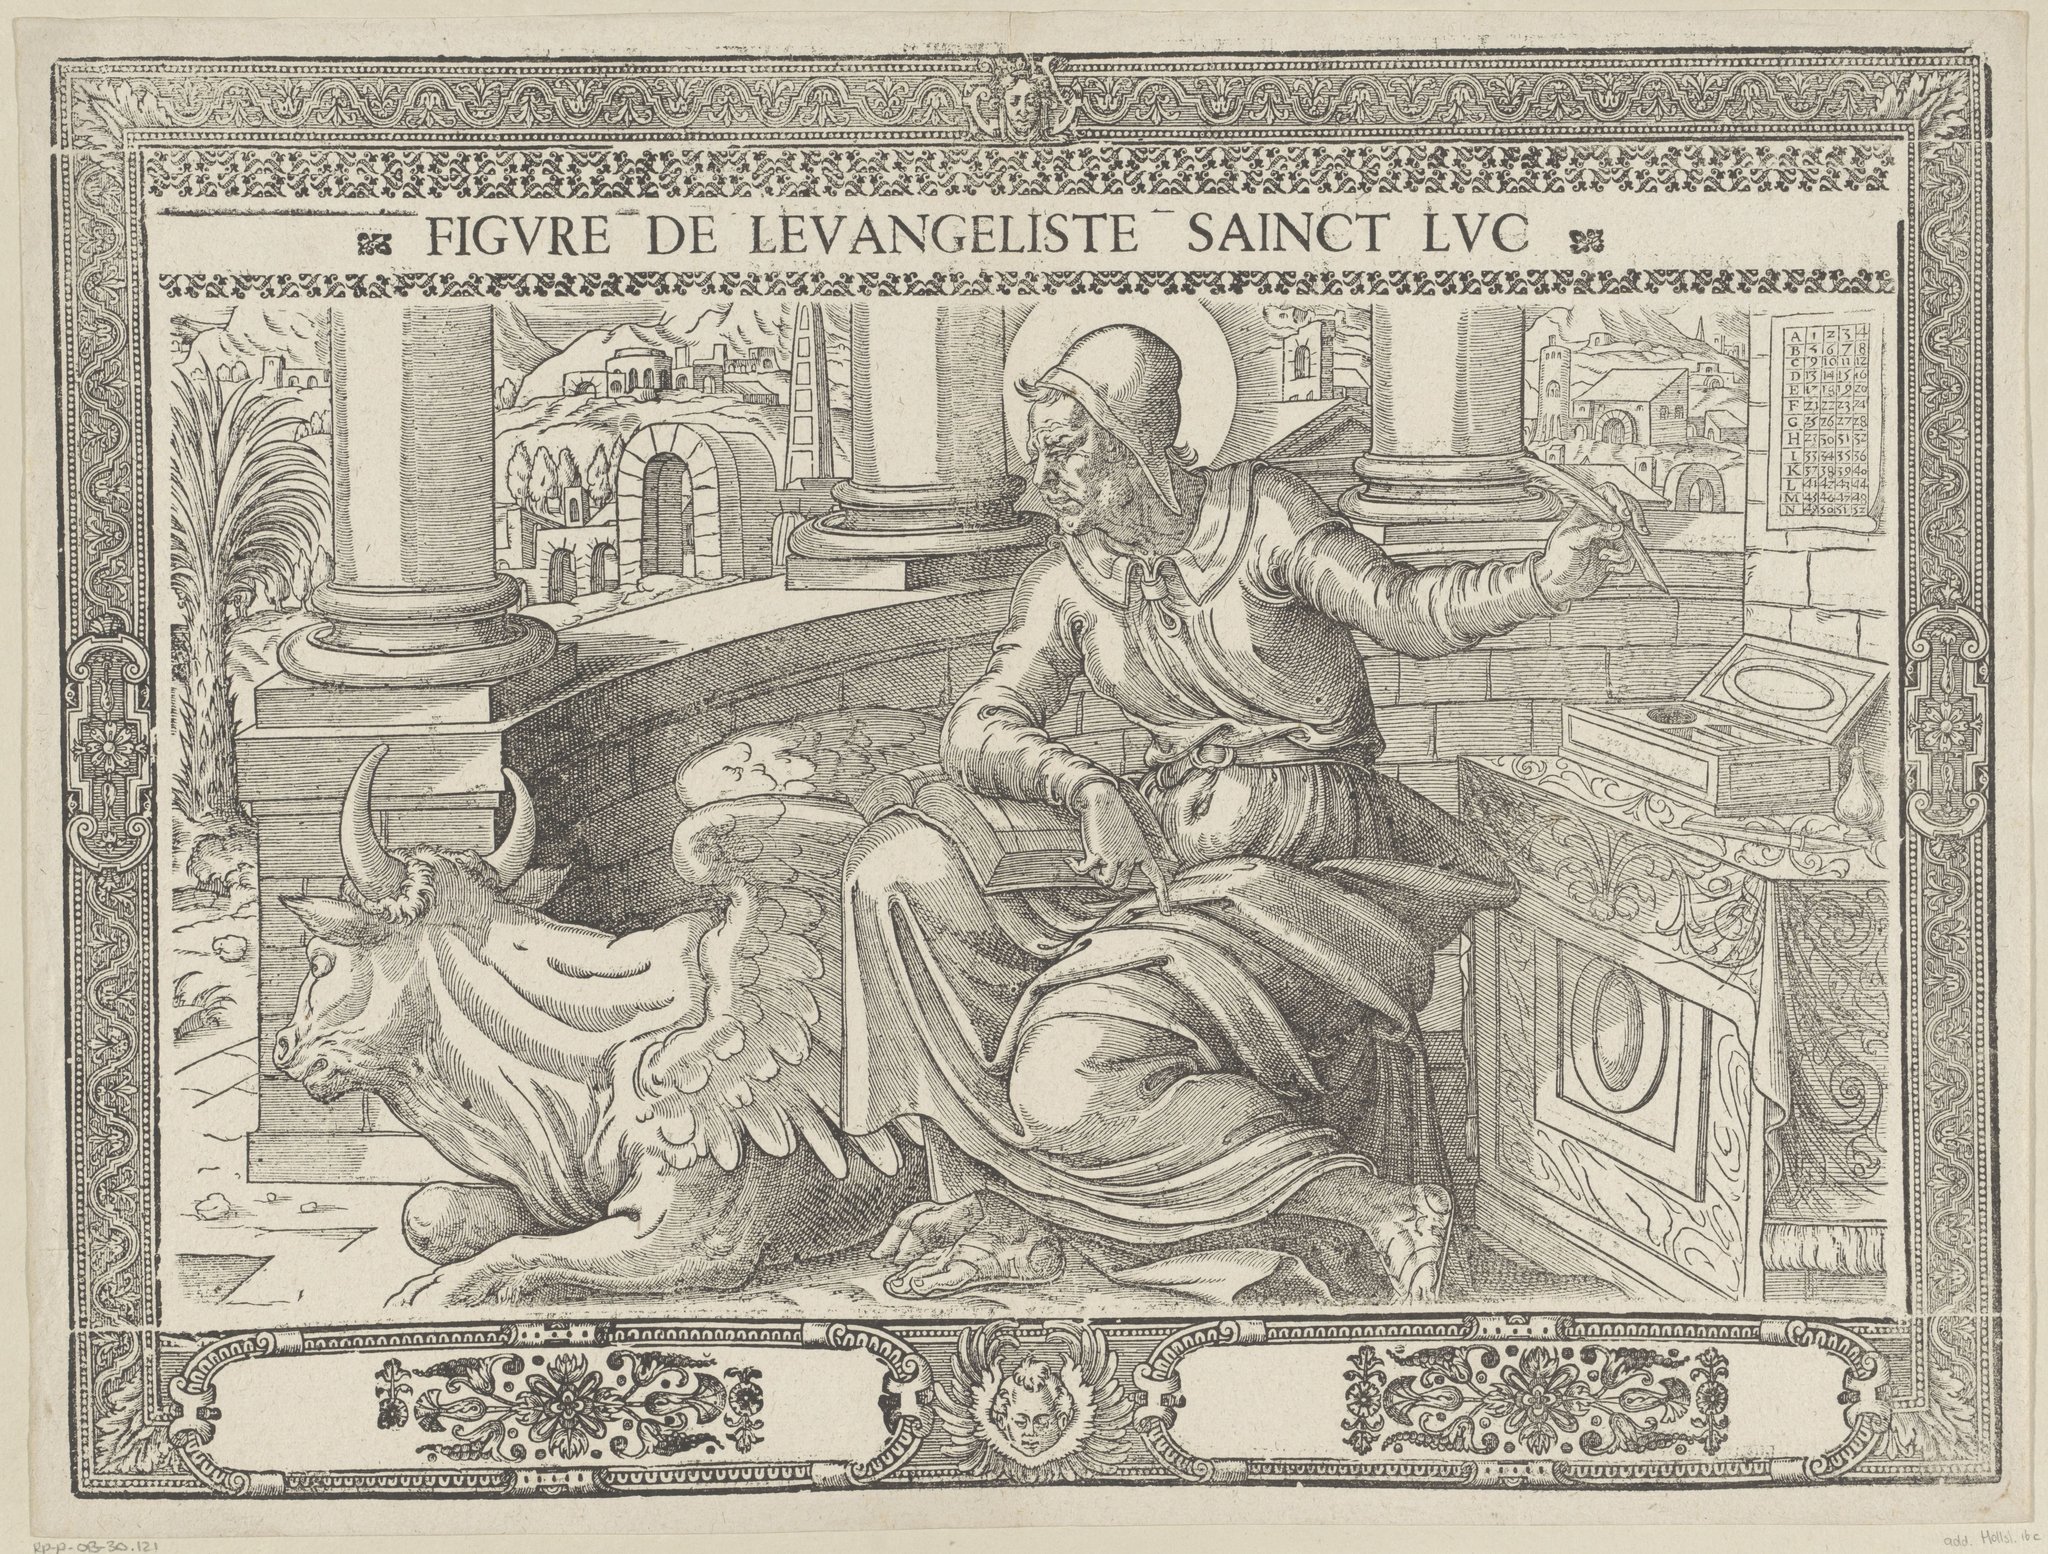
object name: print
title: De vier evangelisten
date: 1572-1575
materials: paper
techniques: woodcut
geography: paris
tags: luke the evangelist; possible attributes: book, (winged) ox, portrait of the virgin, surgical instruments, painter's utensils, scroll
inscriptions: collector's mark: Lugt 240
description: Lucas de evangelist zit gekleed als geneesheer te schrijven in een boek dat op zijn schoot ligt. Aan zijn voeten ligt de os. Op de achtergrond een stad. Geheel in een geornamenteerde omlijsting.